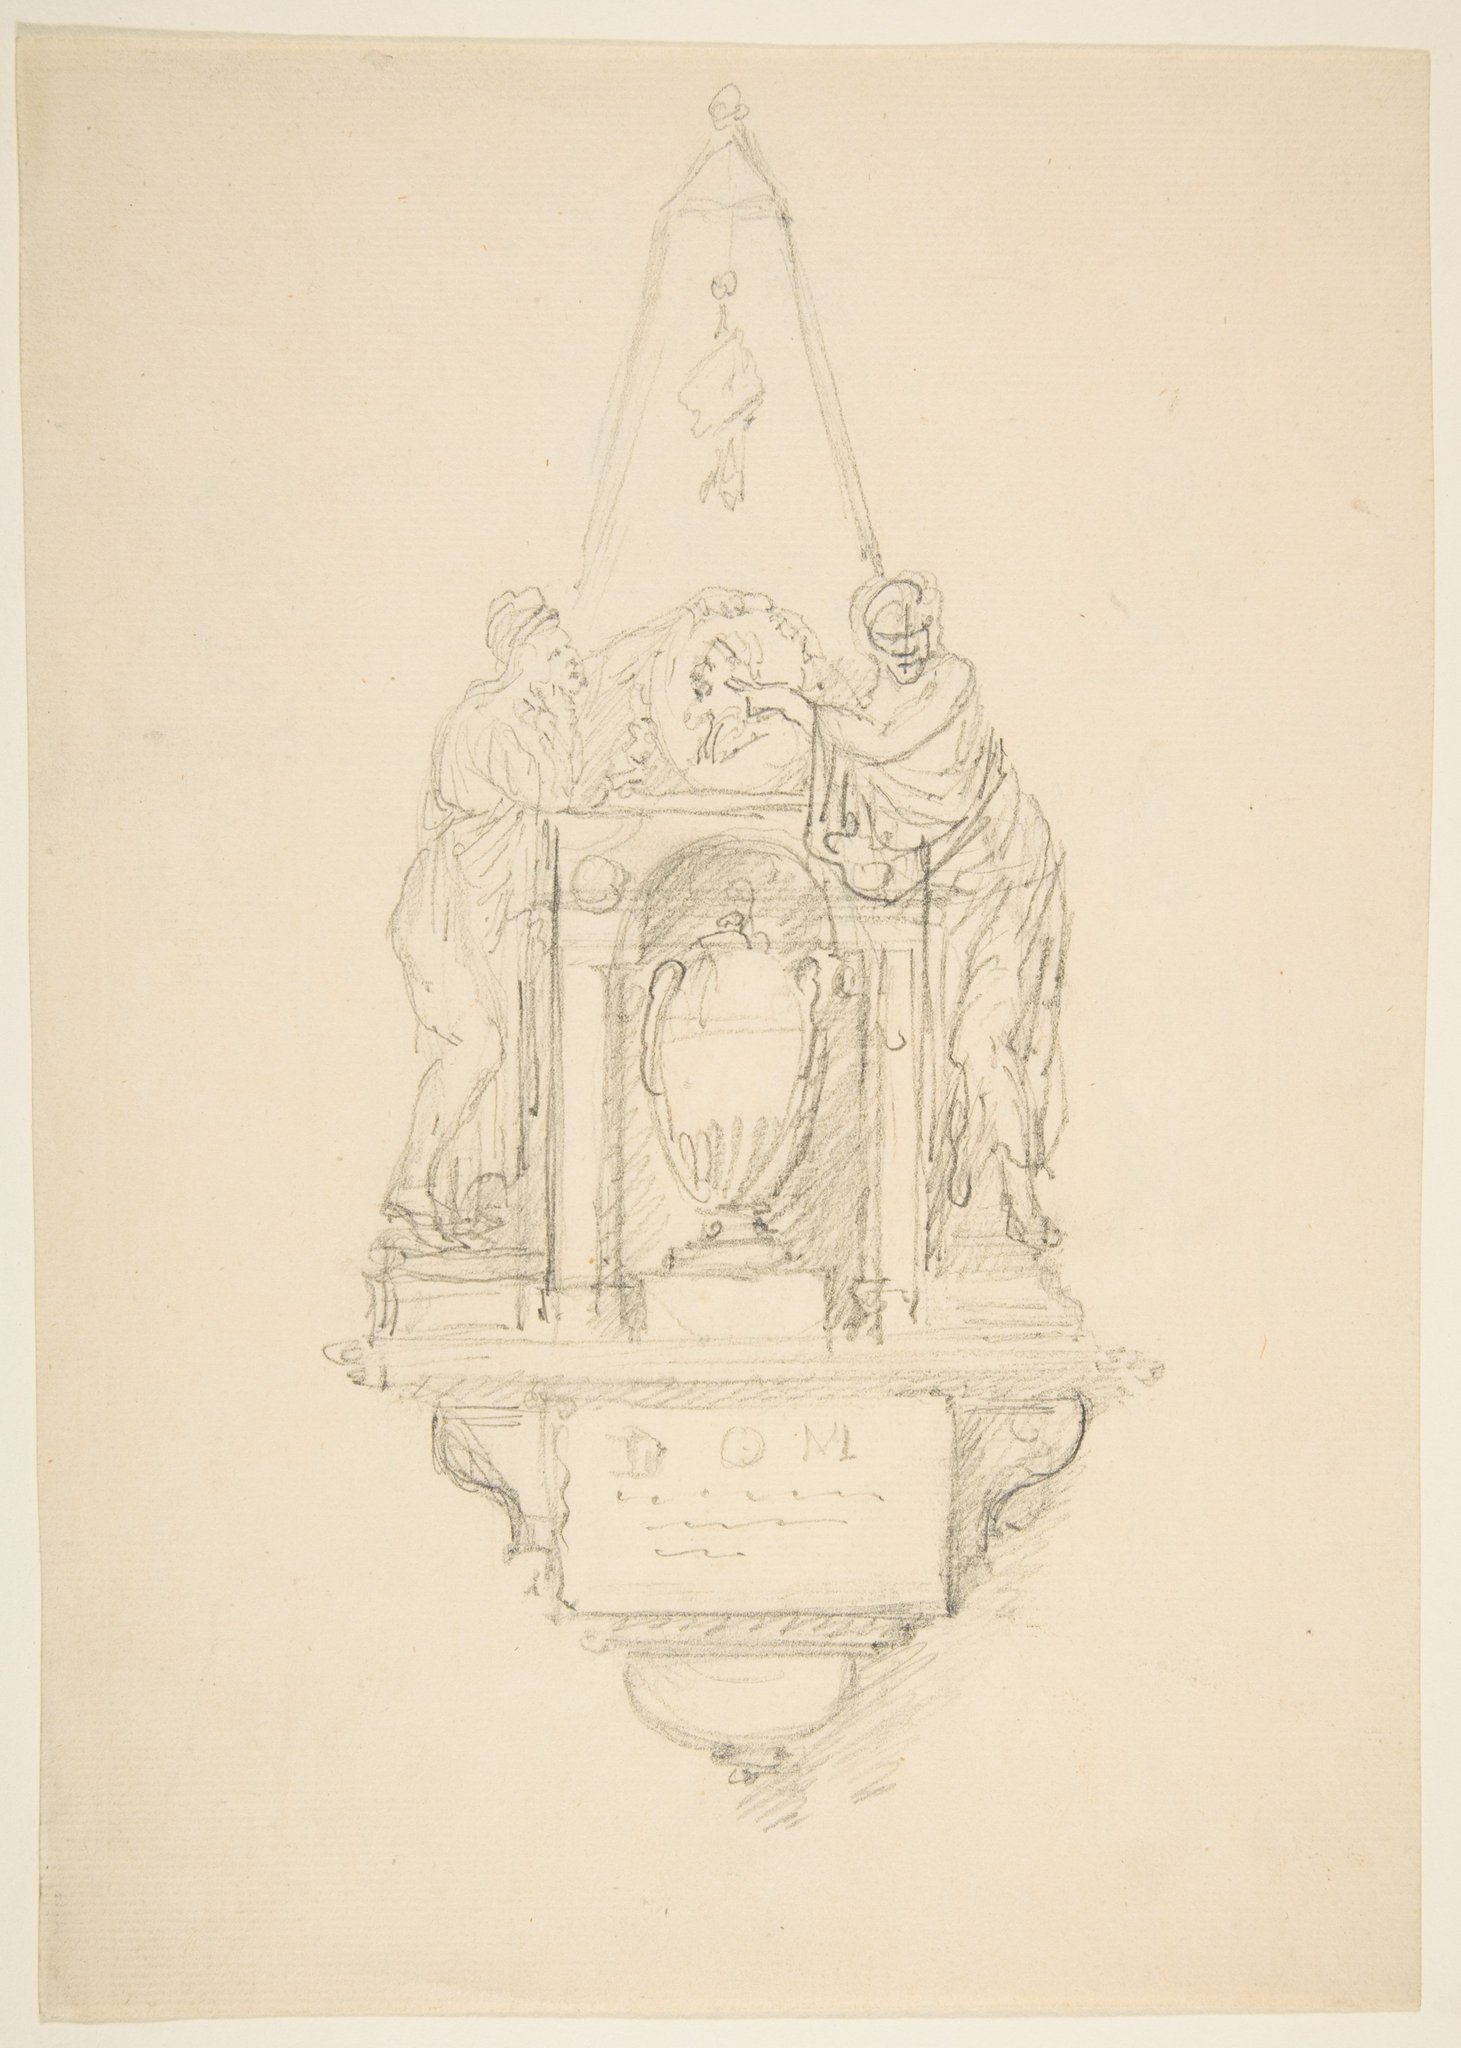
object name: drawing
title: Design for a Monument (recto)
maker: anonymous, french, 19th century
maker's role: artist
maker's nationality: french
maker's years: 1800-1900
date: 1801-1900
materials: graphite, paper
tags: monuments